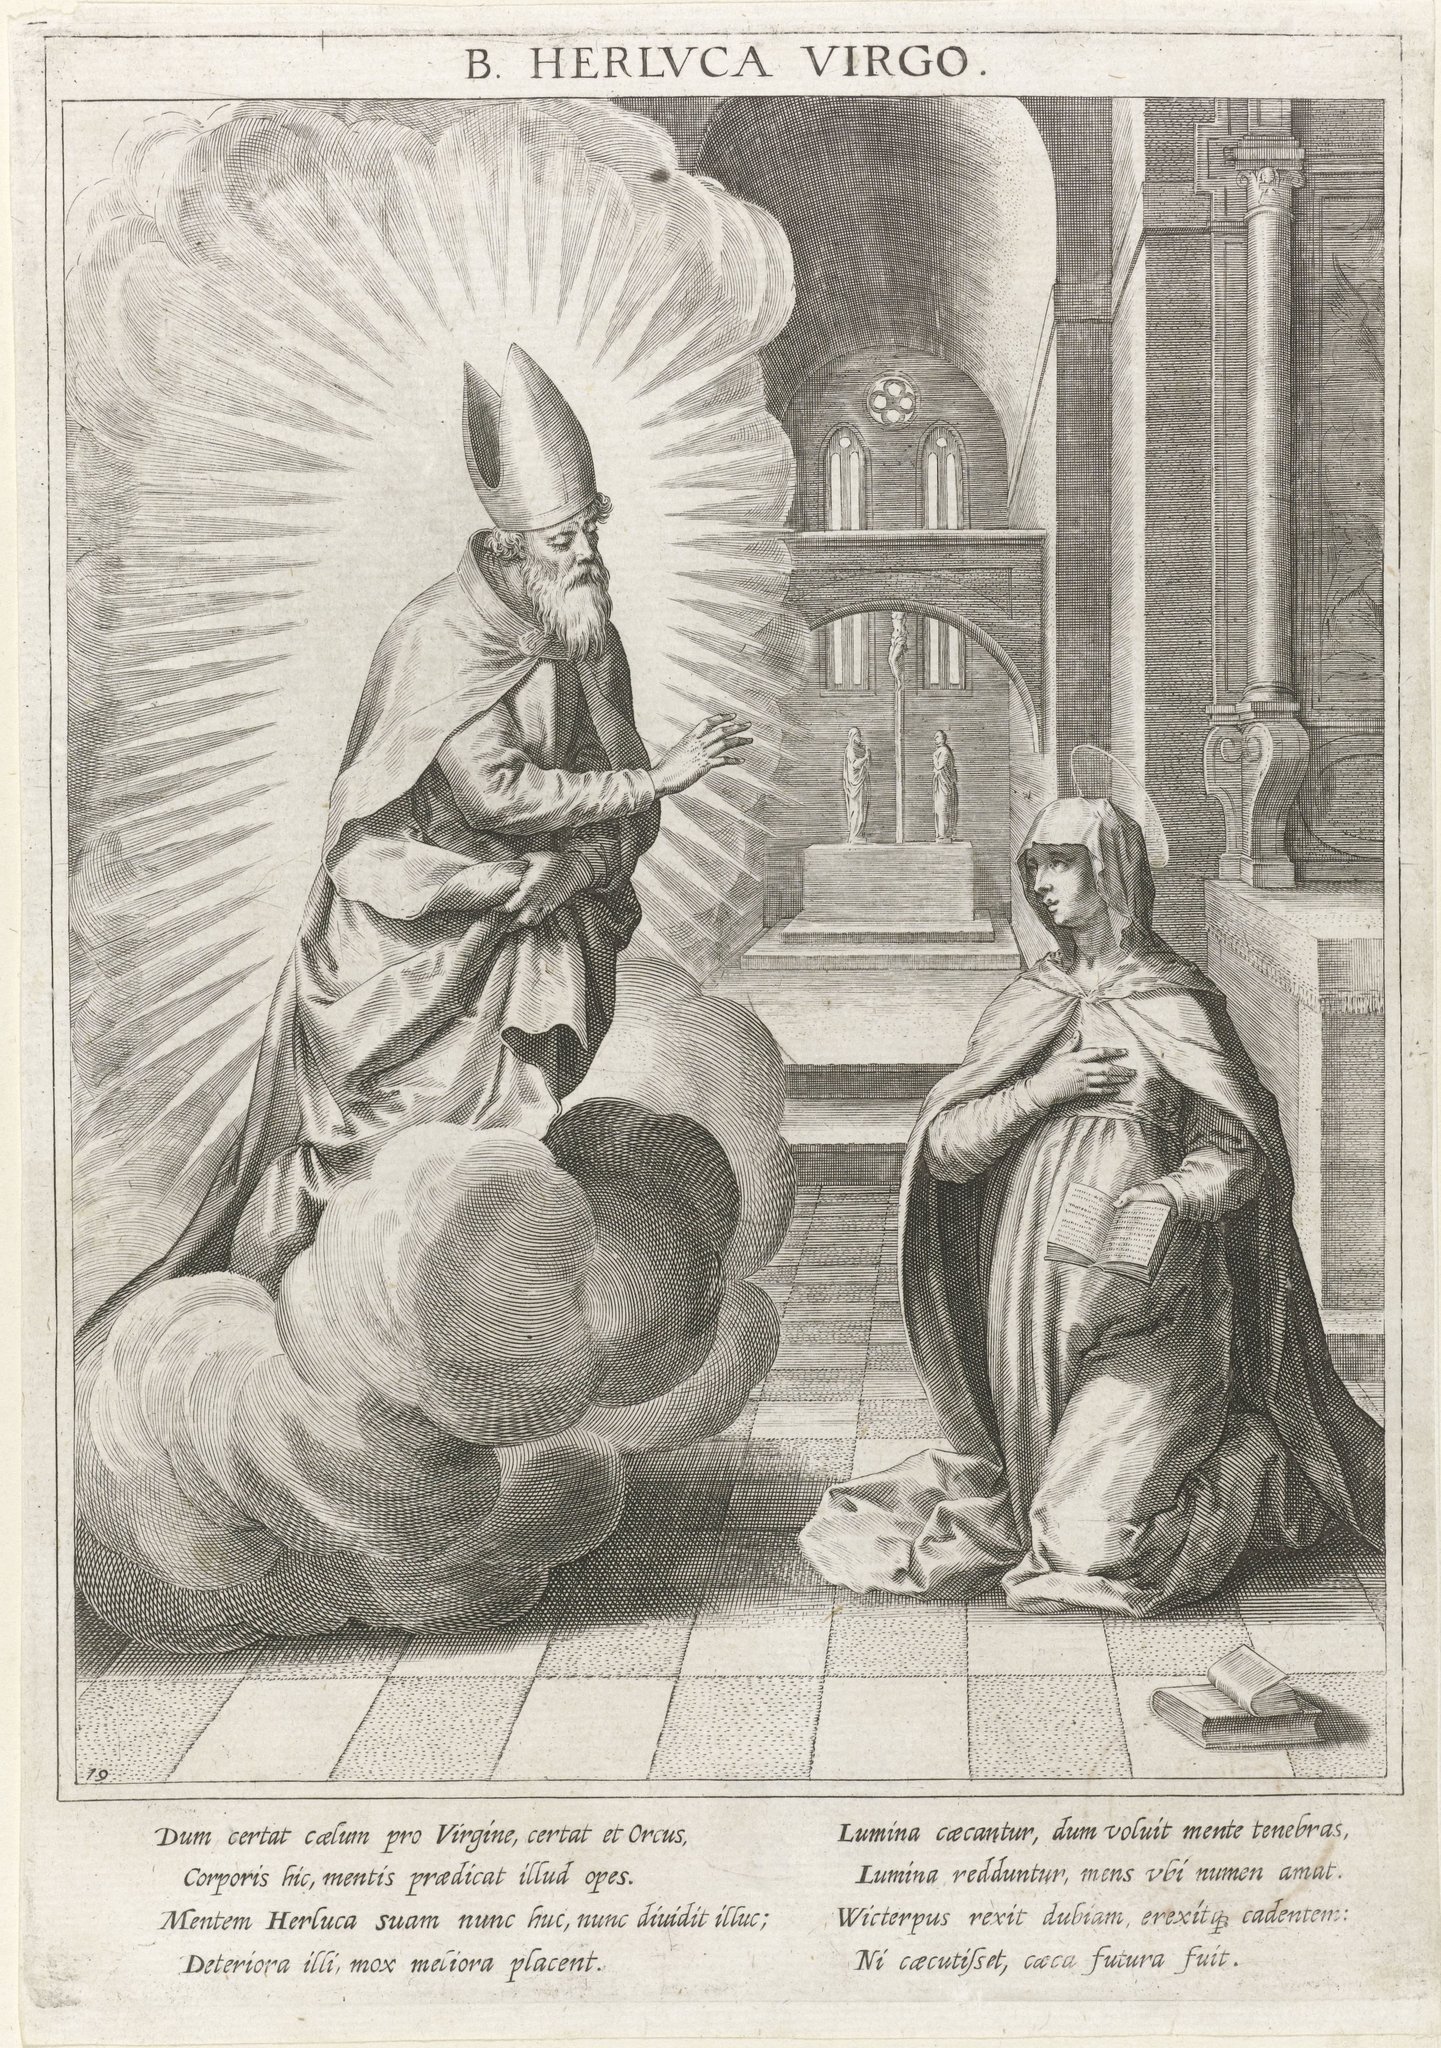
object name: print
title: B. Herlvca virgo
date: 1615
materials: paper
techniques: engraving, etching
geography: munich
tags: male saints (with name), nun(s), saints, interior of church, vision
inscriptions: collector's mark: Lugt 240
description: De blinde non Herluca zit op haar knieën in een kerk. De H. Wigbertus van Ausburg verschijnt aan haar in een visioen. De prent heeft een Latijns onderschrift en is de negentiende prent van een 60-delige serie met als onderwerp de heiligen van Beieren.